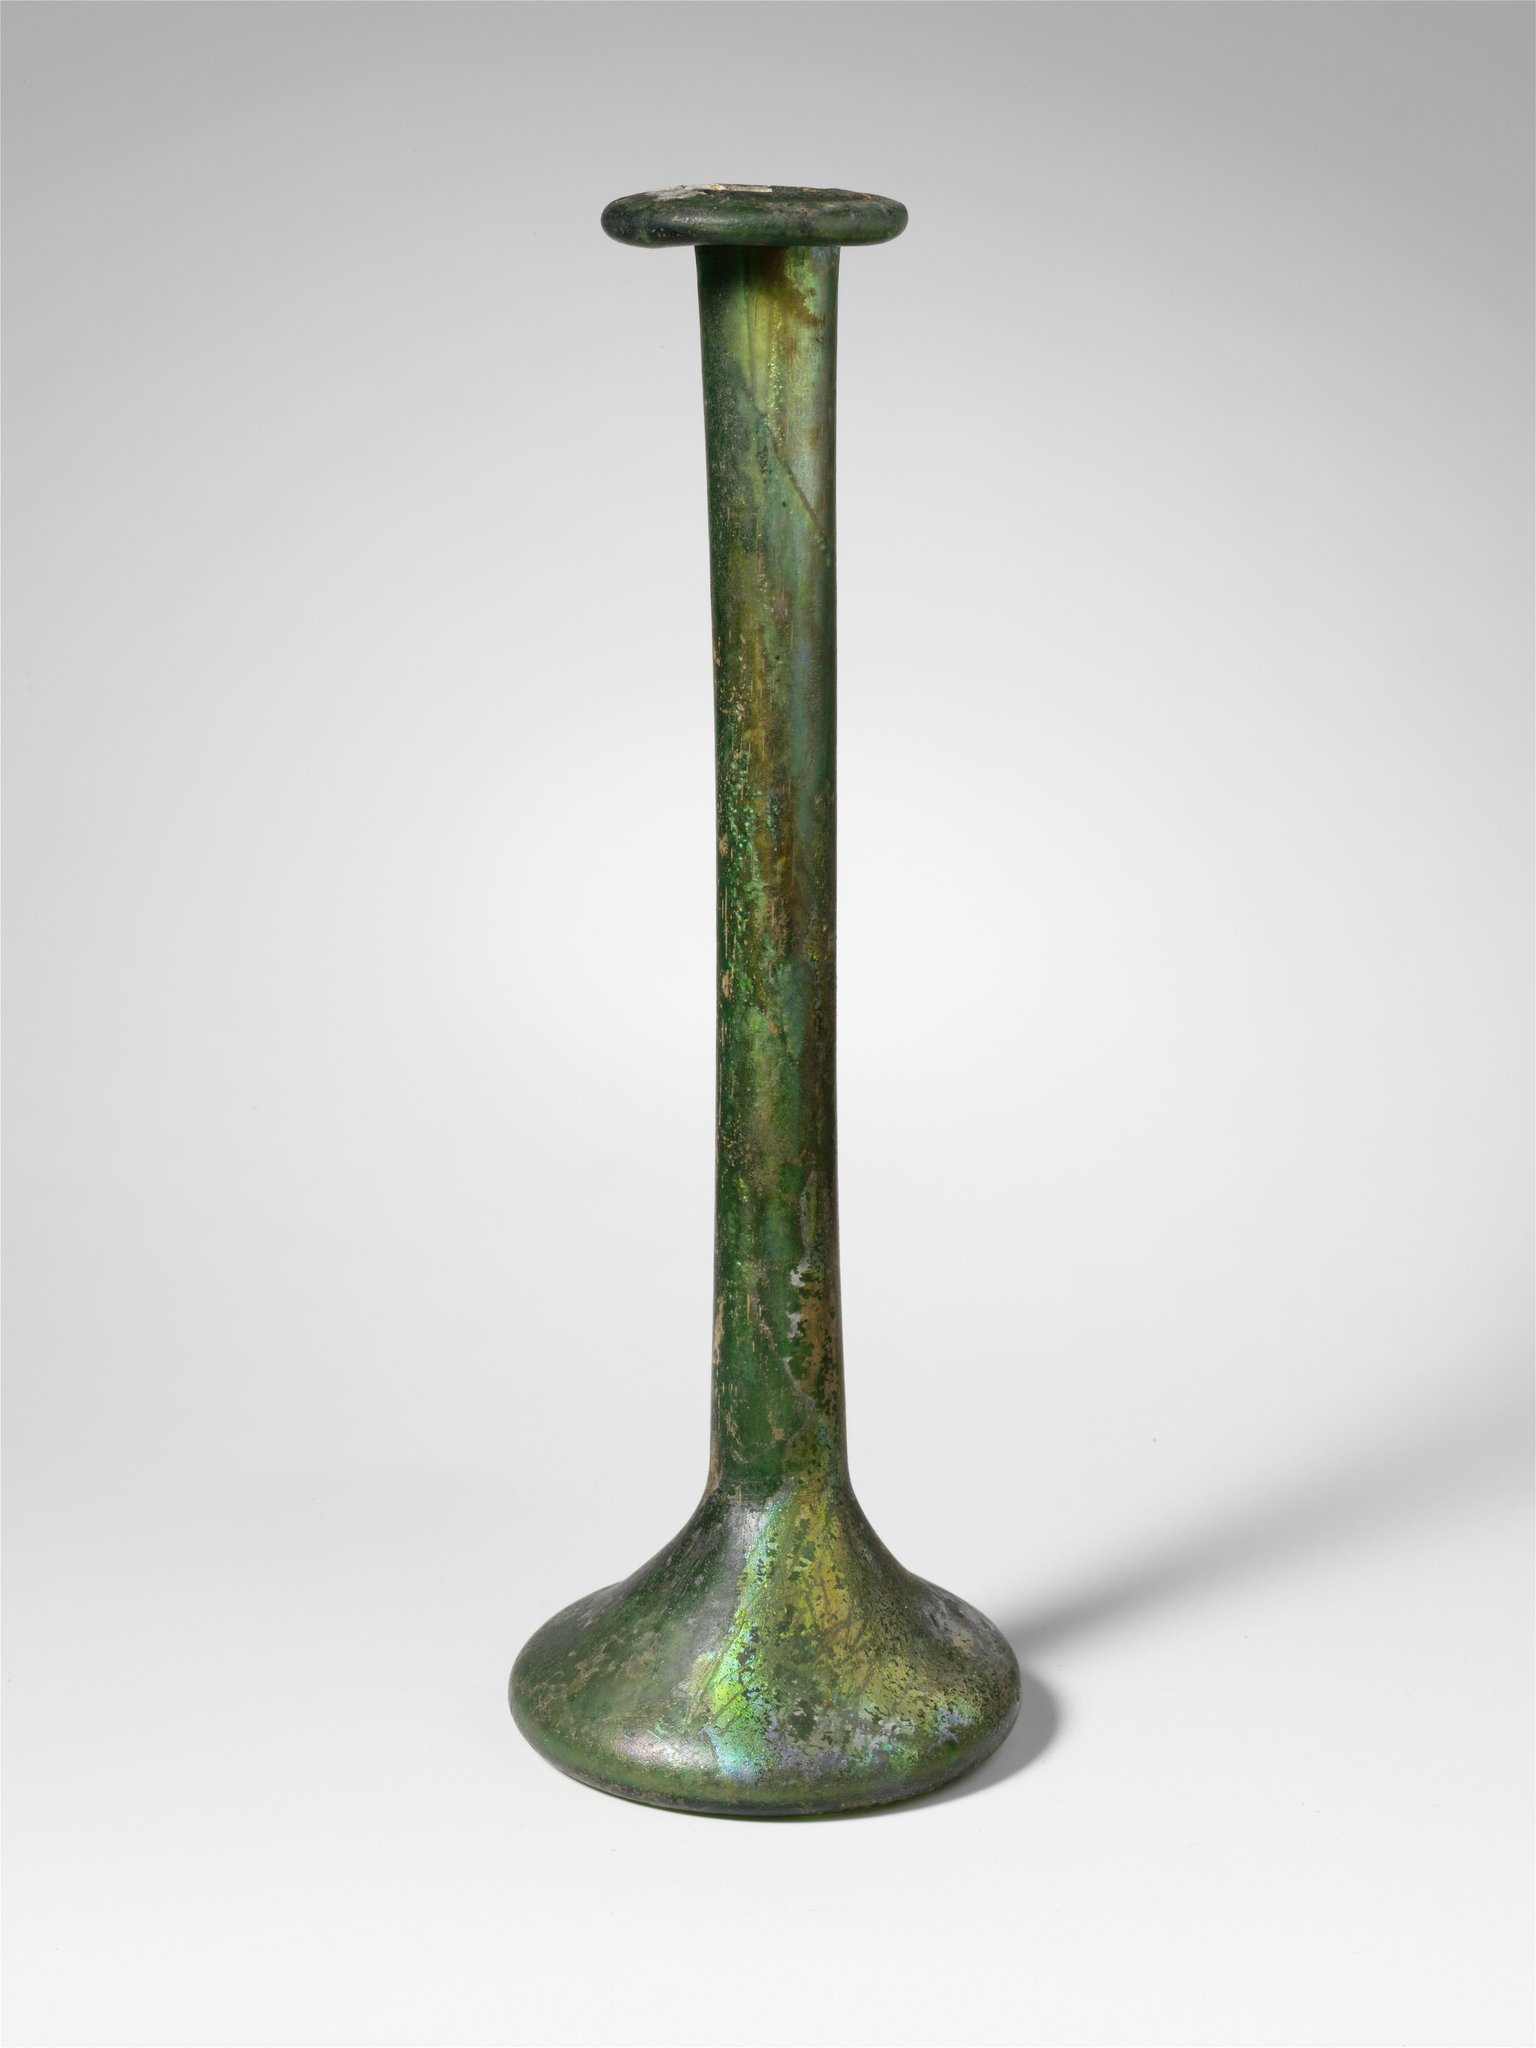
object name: perfume bottle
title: Glass perfume bottle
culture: roman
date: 101-300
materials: glass